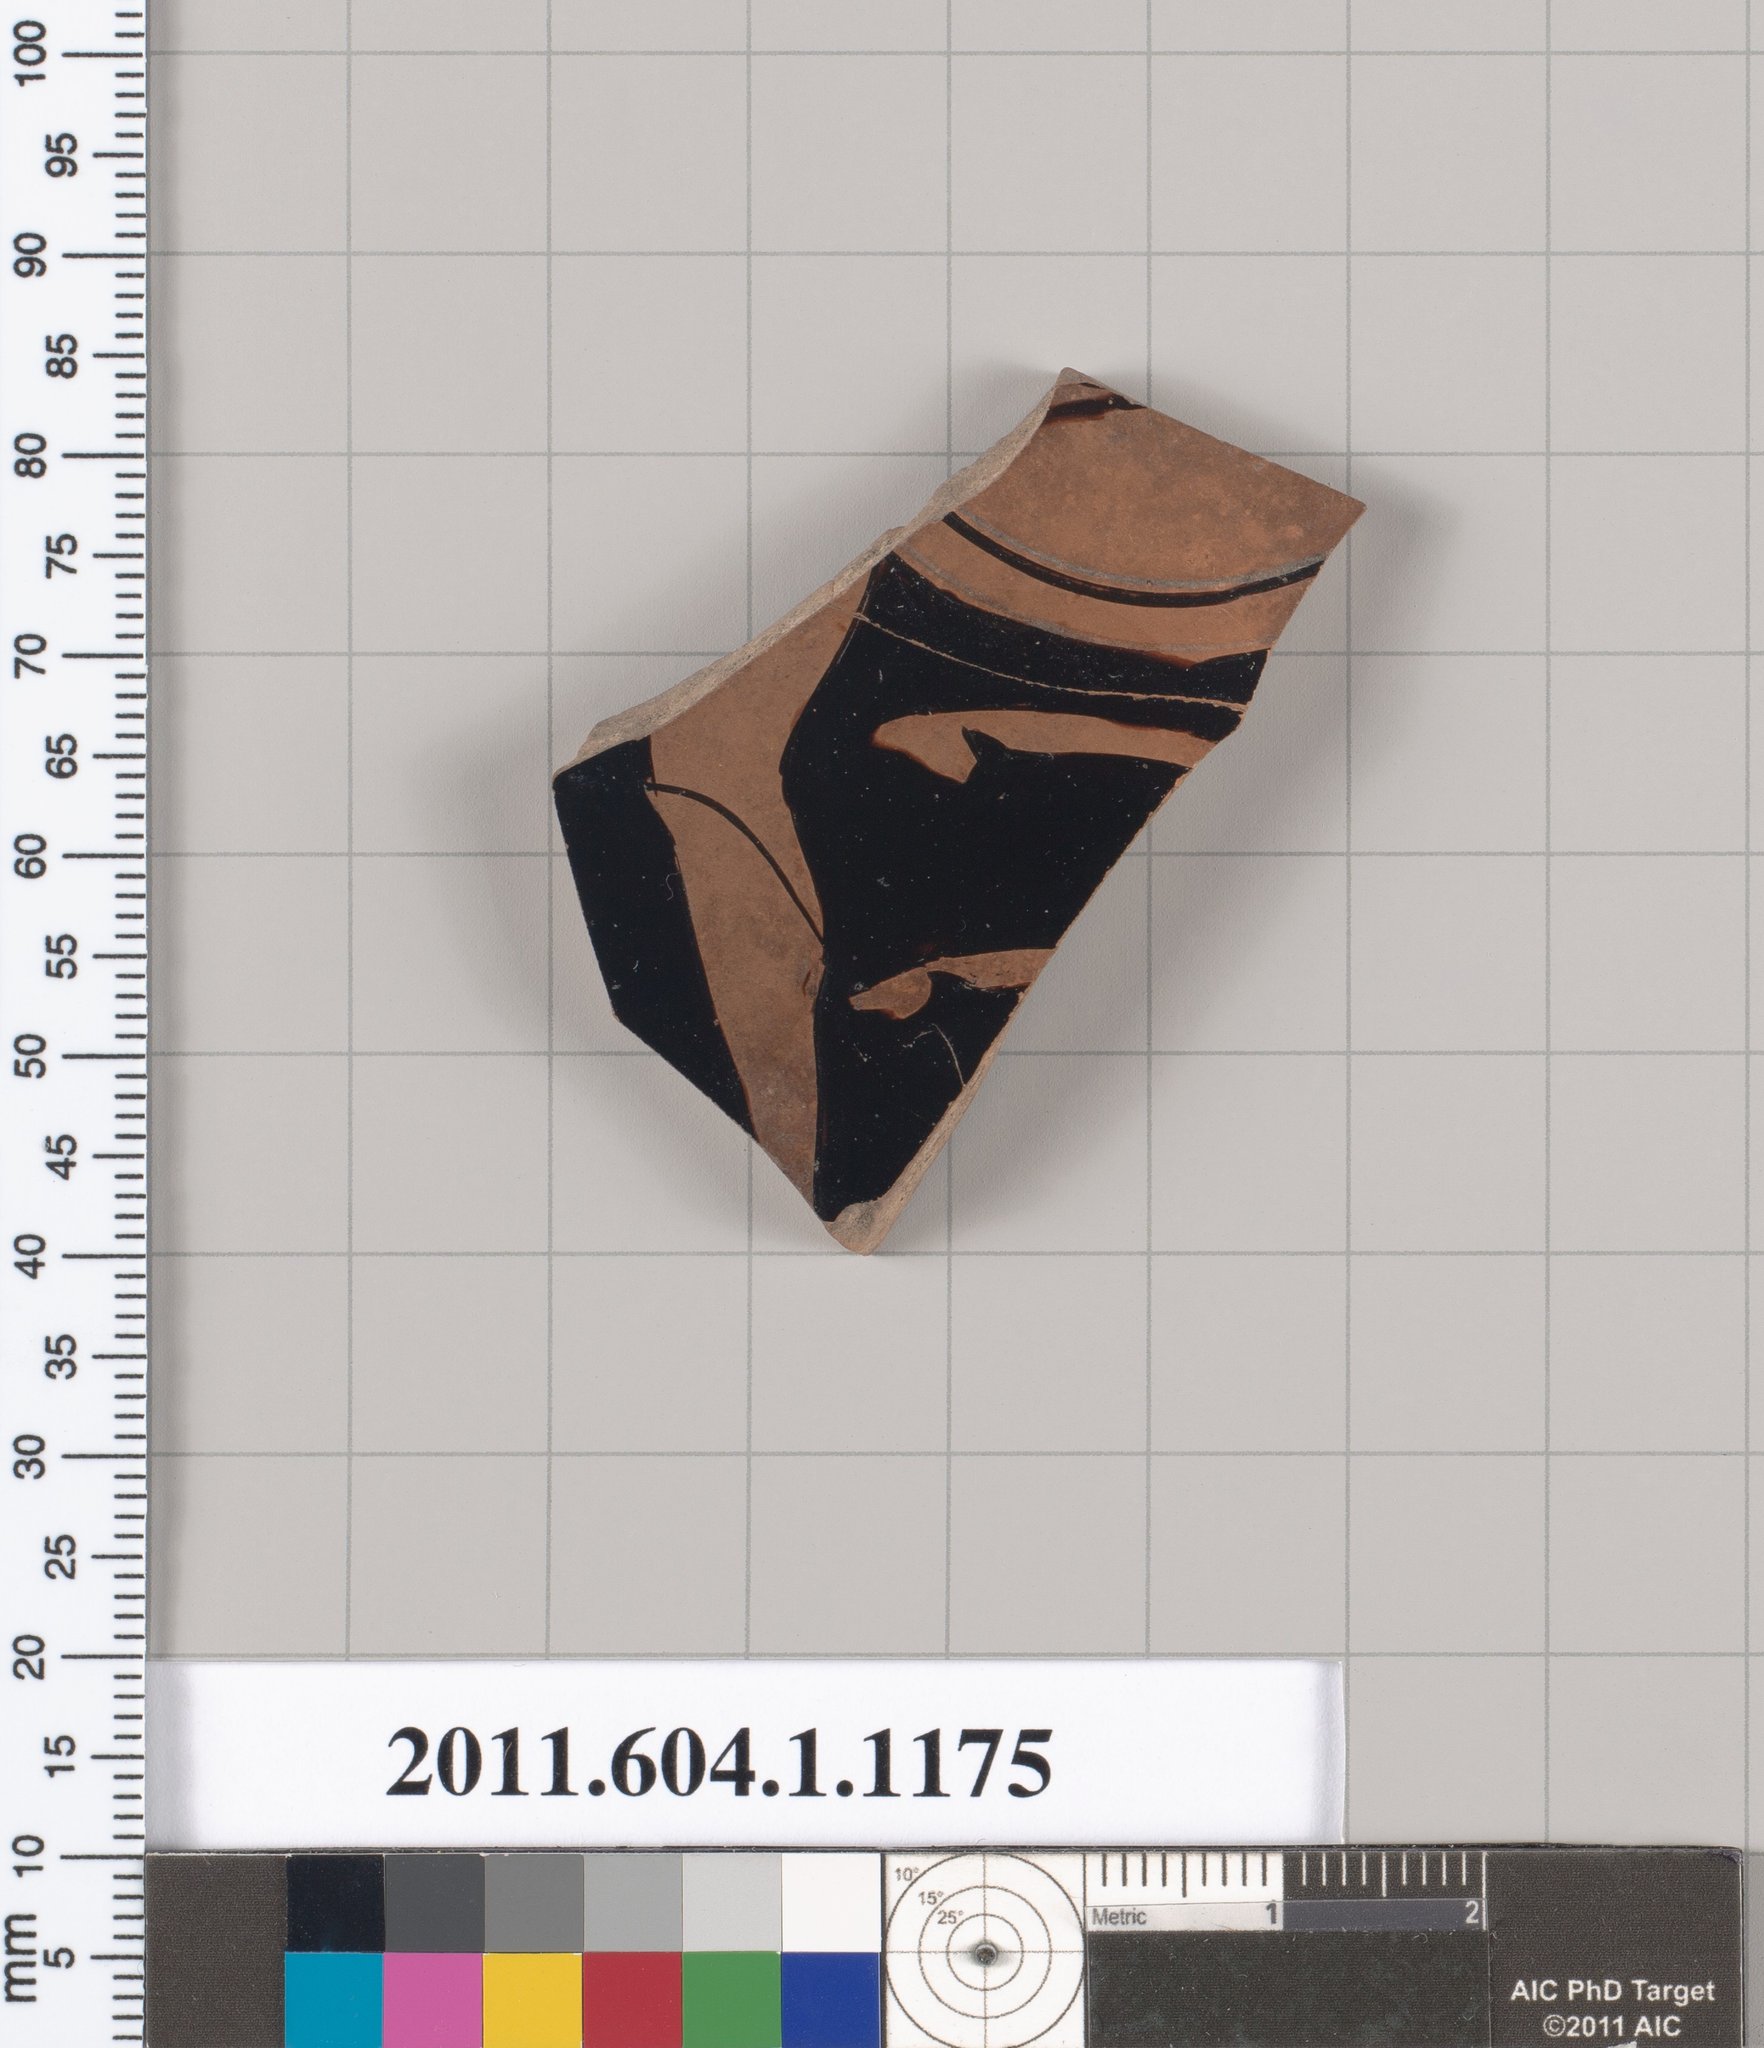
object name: kylix fragment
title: Terracotta fragment of a kylix (drinking cup)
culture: greek, attic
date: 490-480 BCE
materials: terracotta